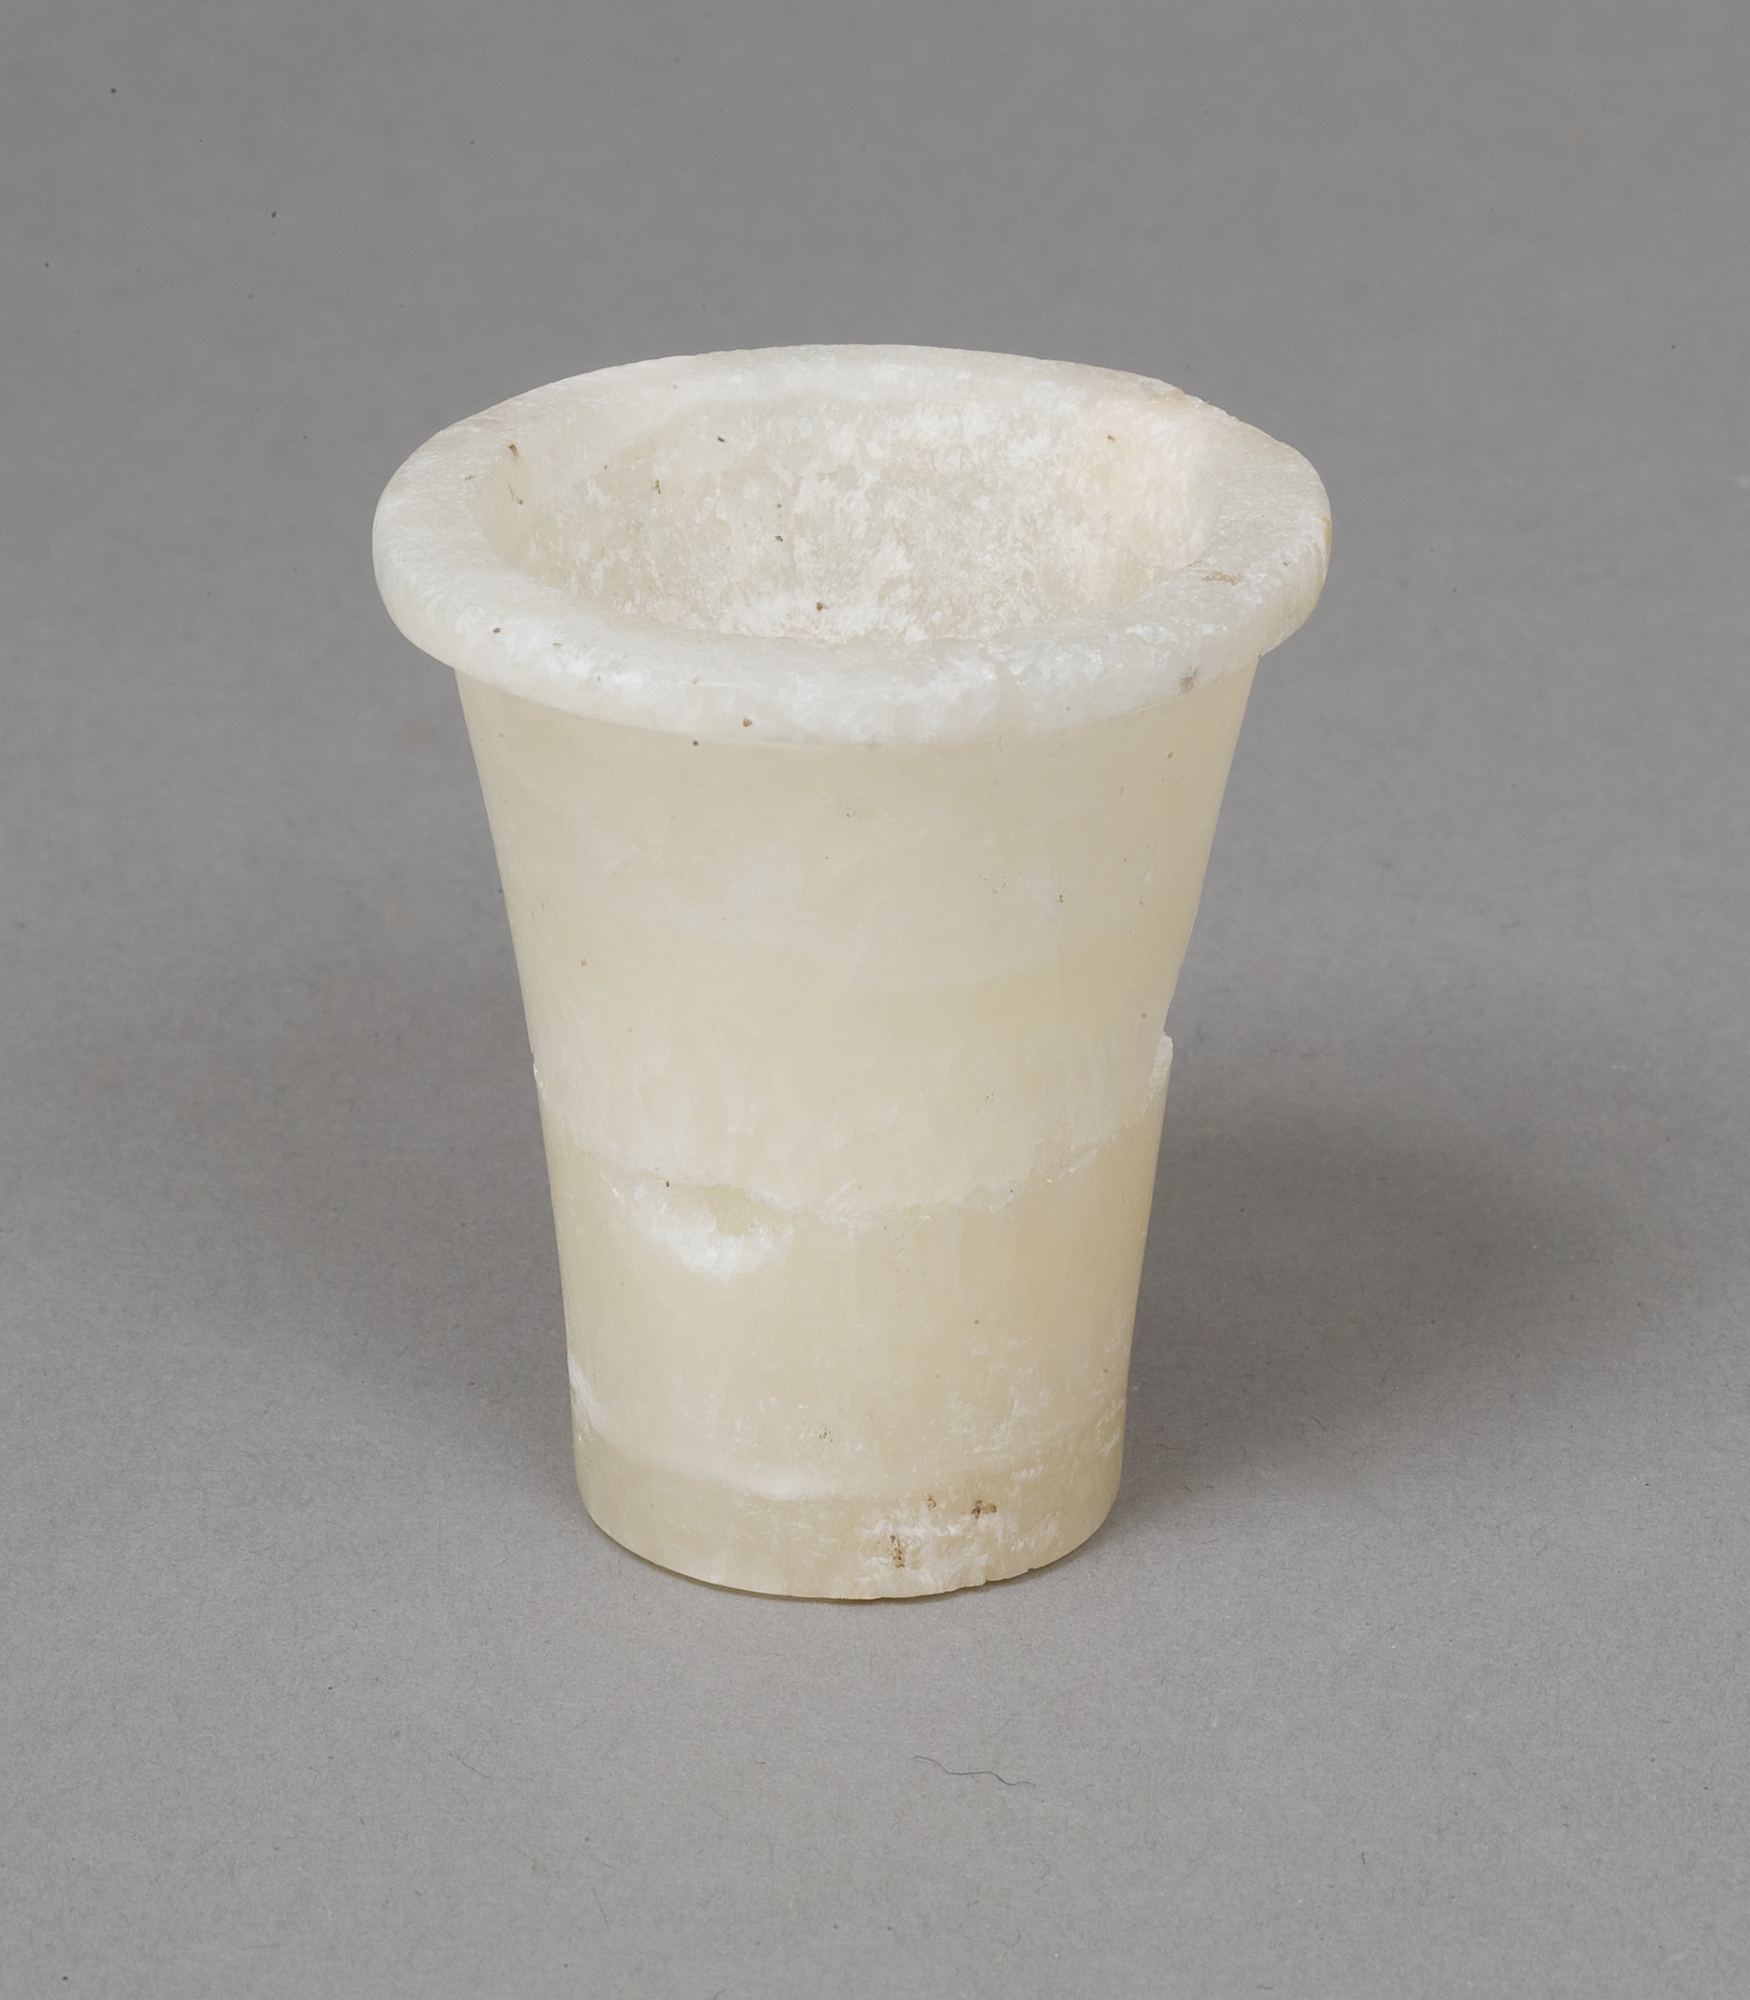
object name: jar, oil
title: Senwosret (?), Oil jar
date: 1950-1850 BCE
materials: stone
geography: egypt